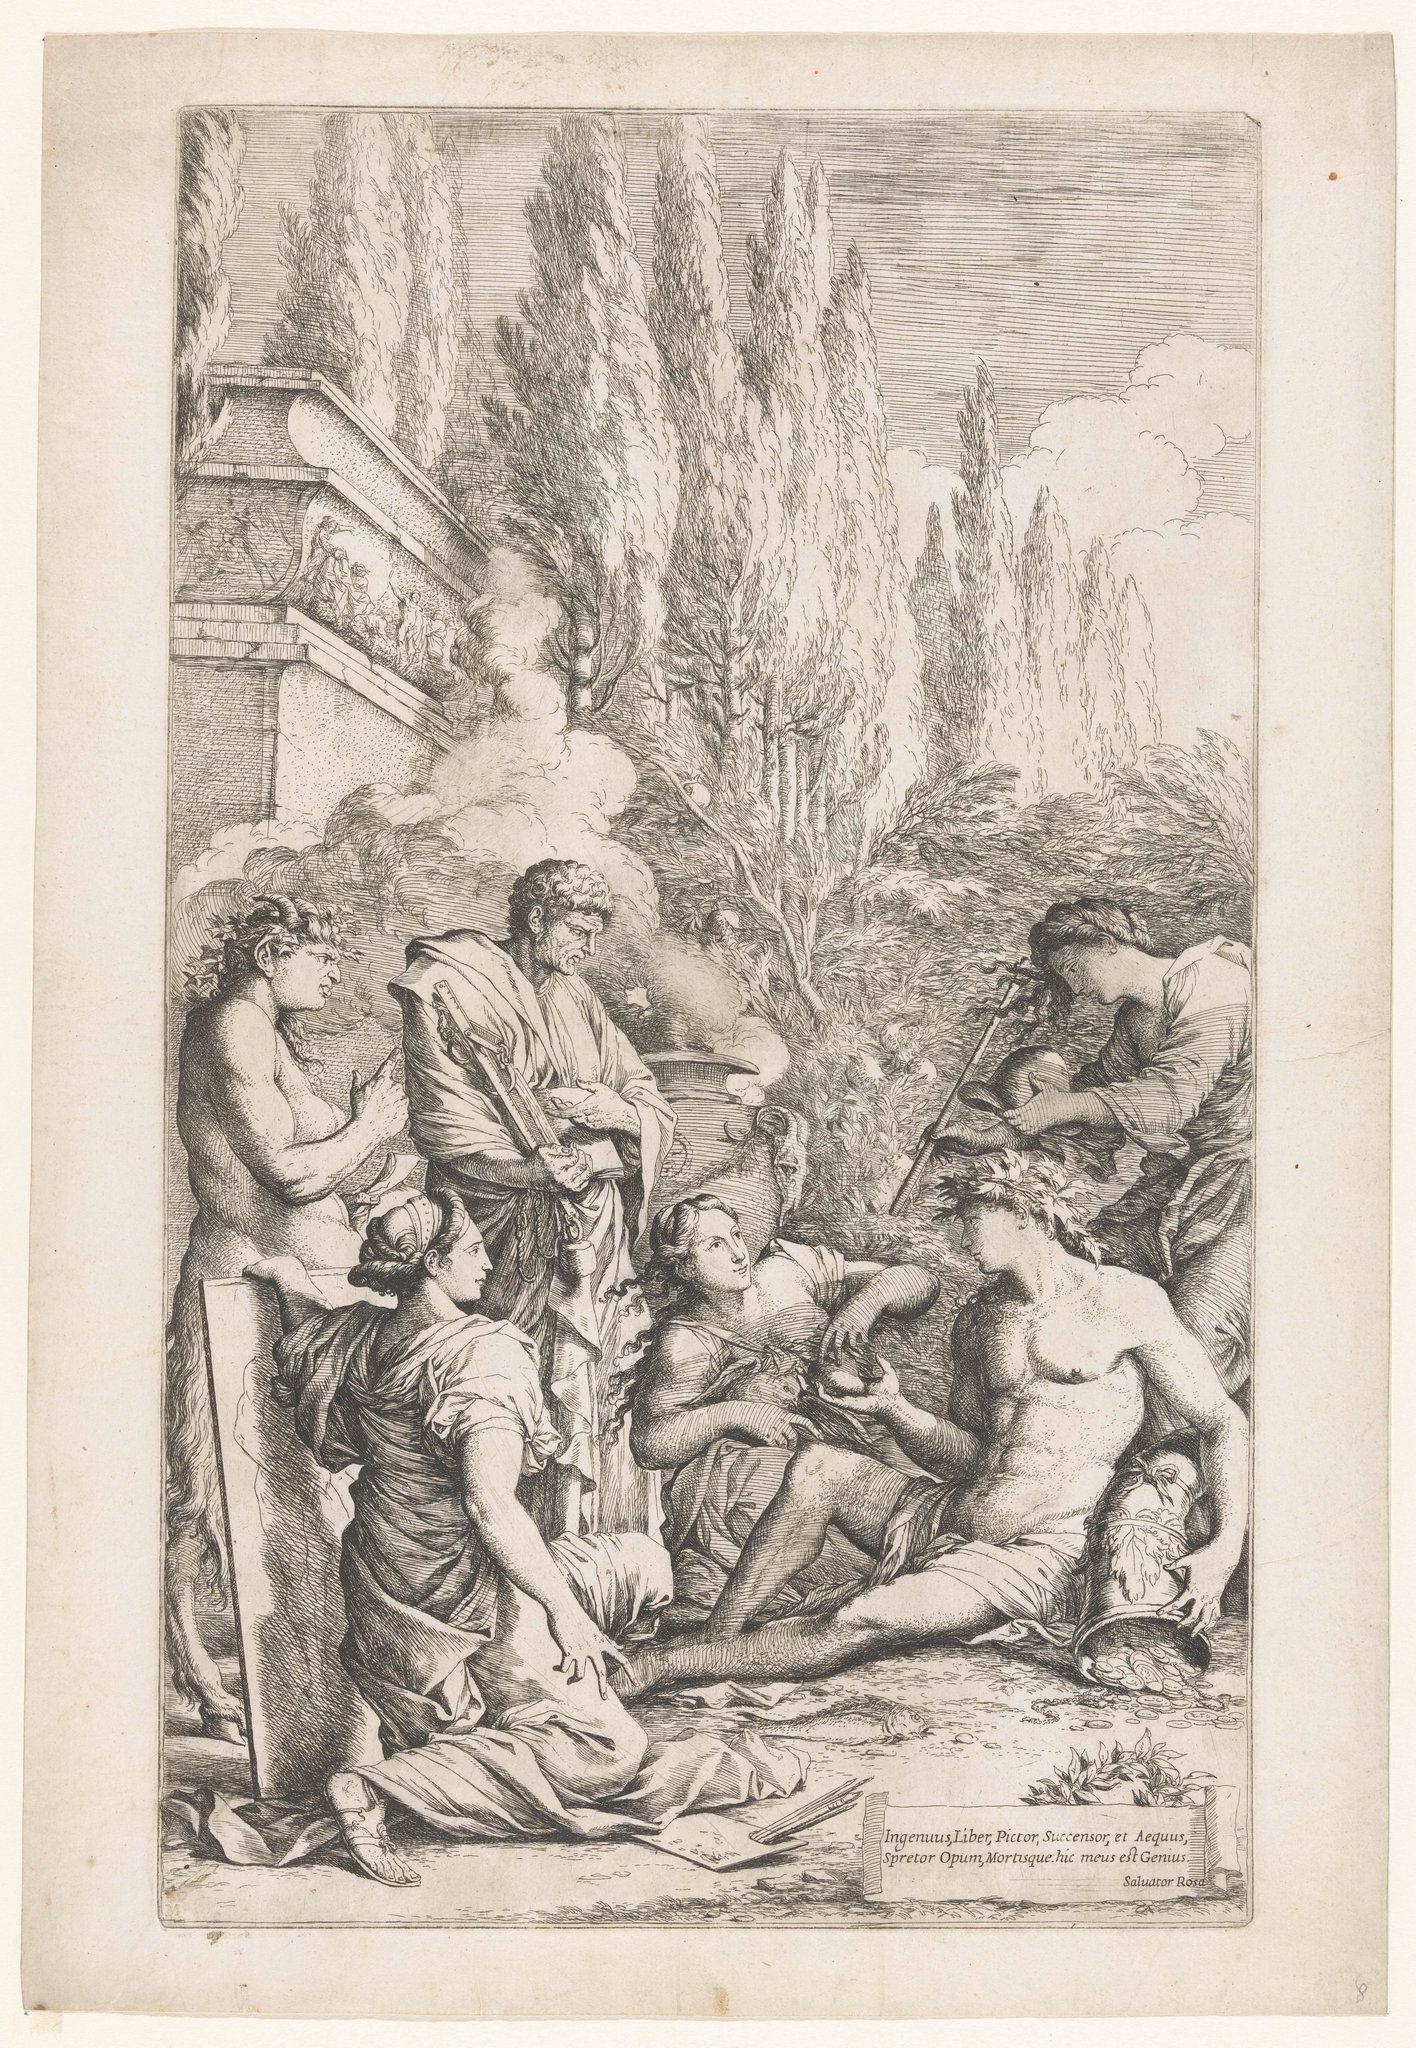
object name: print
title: De genius van Salvator Rosa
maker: salvator rosa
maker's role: draughtsman, painter, print maker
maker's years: 1615-1673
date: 1662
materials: paper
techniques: drypoint, etching, intaglio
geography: italy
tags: 'pictura', symbolic representations, allegories and emblems ~ painting; 'pittura' (ripa), genius, portrait, self-portrait of painter, sarcophagus, freedom, liberty; 'libertà' (ripa), equality, equity, fairness, righteousness; 'equalità', 'equità', 'giuditio giusto', 'ordine dritto e giusto', 'ugualità' (ripa)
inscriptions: collector's mark: Lugt 1842, inscription: ‘[...]’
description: Salvator Rosa zit rechts op de grond met zijn hand rustend op een hoorn des overvloeds (cornucopia). Met zijn andere hand geeft hij zijn hart aan Eerlijkheid (Sinceritas), een vrouwelijke figuur met een duif. Rechts achter de kunstenaar staat Vrijheid (Libertas). Links op de voorgrond knielt Schilderkunst (Pictura) met een schilderij en schilderspalet en voor haar op de grond een vis. Achter haar staan een sater en Gelijkheid (Aequitas), in toga gekleed. Op de achtergrond een sarcofaag. Rechtsonder twee regels Latijnse tekst.